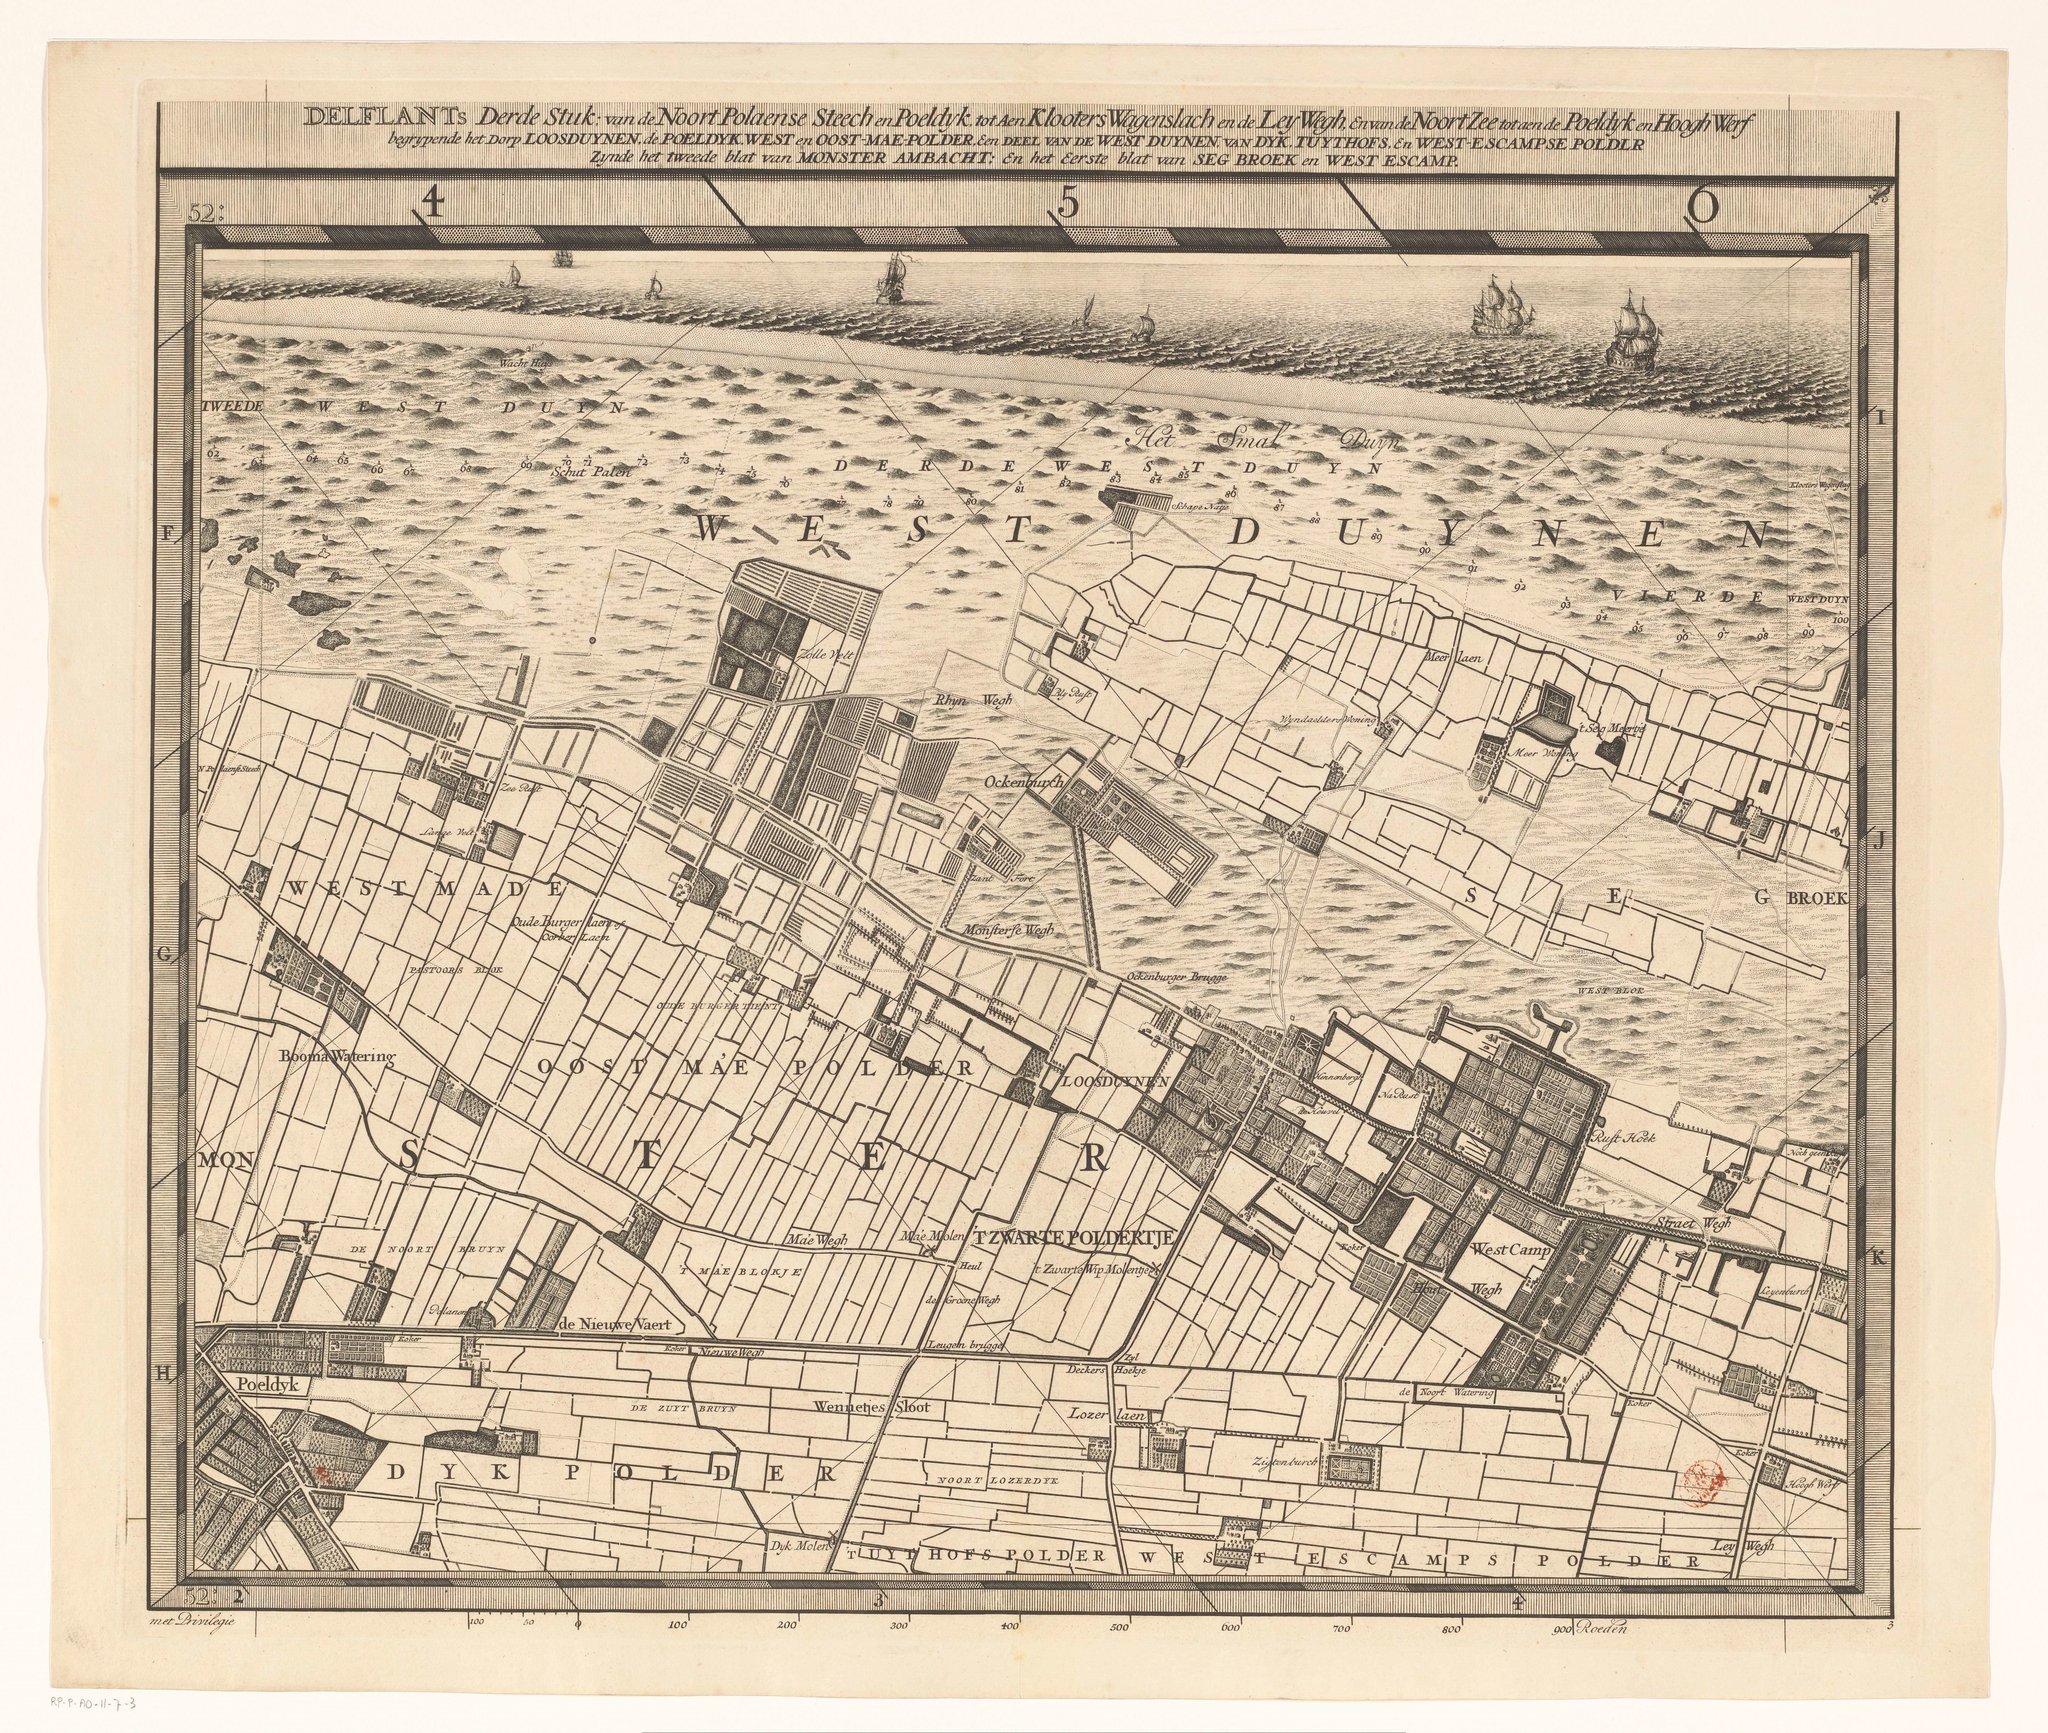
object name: print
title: Kaart van het Hoogheemraadschap van Delfland (derde deel)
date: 1712-1735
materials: paper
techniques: engraving, etching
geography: delft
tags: maps of cities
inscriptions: collector's mark: Lugt 195, collector's mark: Lugt 2228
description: Onderdeel van de grote wandkaart 'T Hooge Heemraedschap van Delflant. De kaart zelf bestaat uit vijfentwintig bladen, de titelstrook is gedrukt van twee platen. Meerdere prentmakers hebben aan deze kaart gewerkt. In volgorde van meest gewerkte dagen zijn dit: Luggert van Anse (1091 dagen), Thomas Doesburgh (952 dagen), Jacobus Deur (806 dagen), Johannes Deur (683 dagen) en Pieter Sluyter (151 dagen). Sluyter was verantwoordelijk voor de versieringen, de anderen voor de rest. Wie precies aan welk blad heeft gewerkt is niet duidelijk. Pieter Haringh had het ontwerp voor de wapenschilden geleverd en Arnold Houbraken het ontwerp voor de rest van de versieringen. Het drukken, uitgeven en verkopen van de kaart lag, zoals blijkt uit het privilege, in handen van het hoogheemraadschap. Voor zover bekend is de kaart in zijn geheel twee keer gedrukt, in 1712 en 1735. Het hoogheemraadschap beheerde de voorraad kaarten voor verkoop. In een aantal atlassen van Covens & Mortier (Nieuwe atlas inhoudende de vier gedeeltens der waereld (...). 5 delen. Amsterdam: Covens & Mortier, s.a. [1721-1759], dl. 3) zijn de zevenentwintig bladen van de kaart en de overzichtskaart opgenomen. Het is dus vermoedelijk niet zo dat de kaart voor deze atlassen opnieuw werd gedrukt. Waarschijnlijk werd een aantal exemplaren bij het hoogheemraadschap afgenomen.